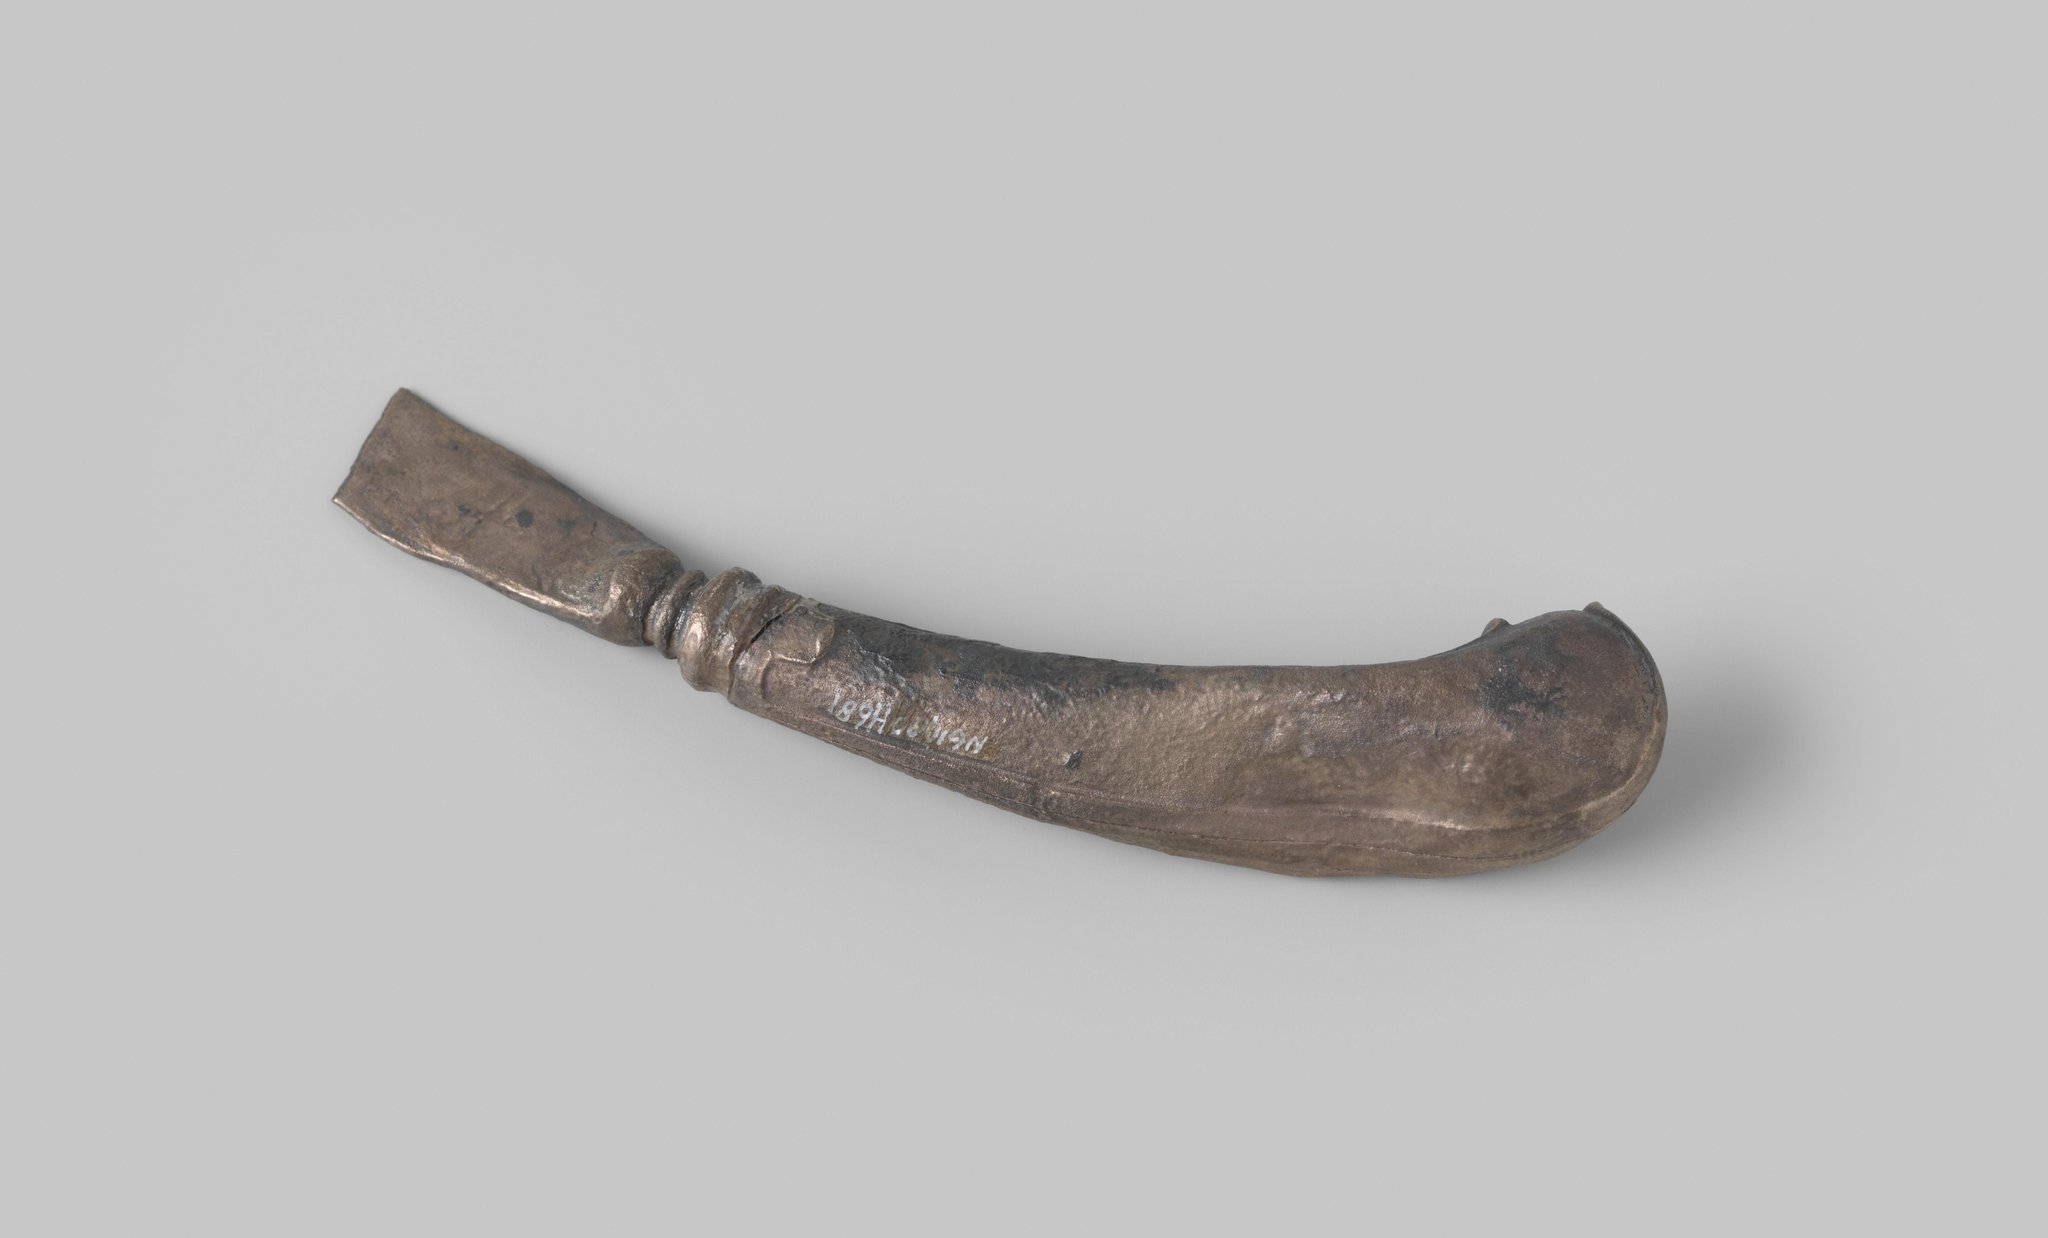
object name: knife tool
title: Mes uit het wrak van de Oost-Indiëvaarder Hollandia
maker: Anonymous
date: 1700-1743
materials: silver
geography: netherlands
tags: verenigde oostindische compagnie, hollandia (schip), annet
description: Cutlery, knive; (1)fragm, rear end of blade, part of NG 1980-27H681.